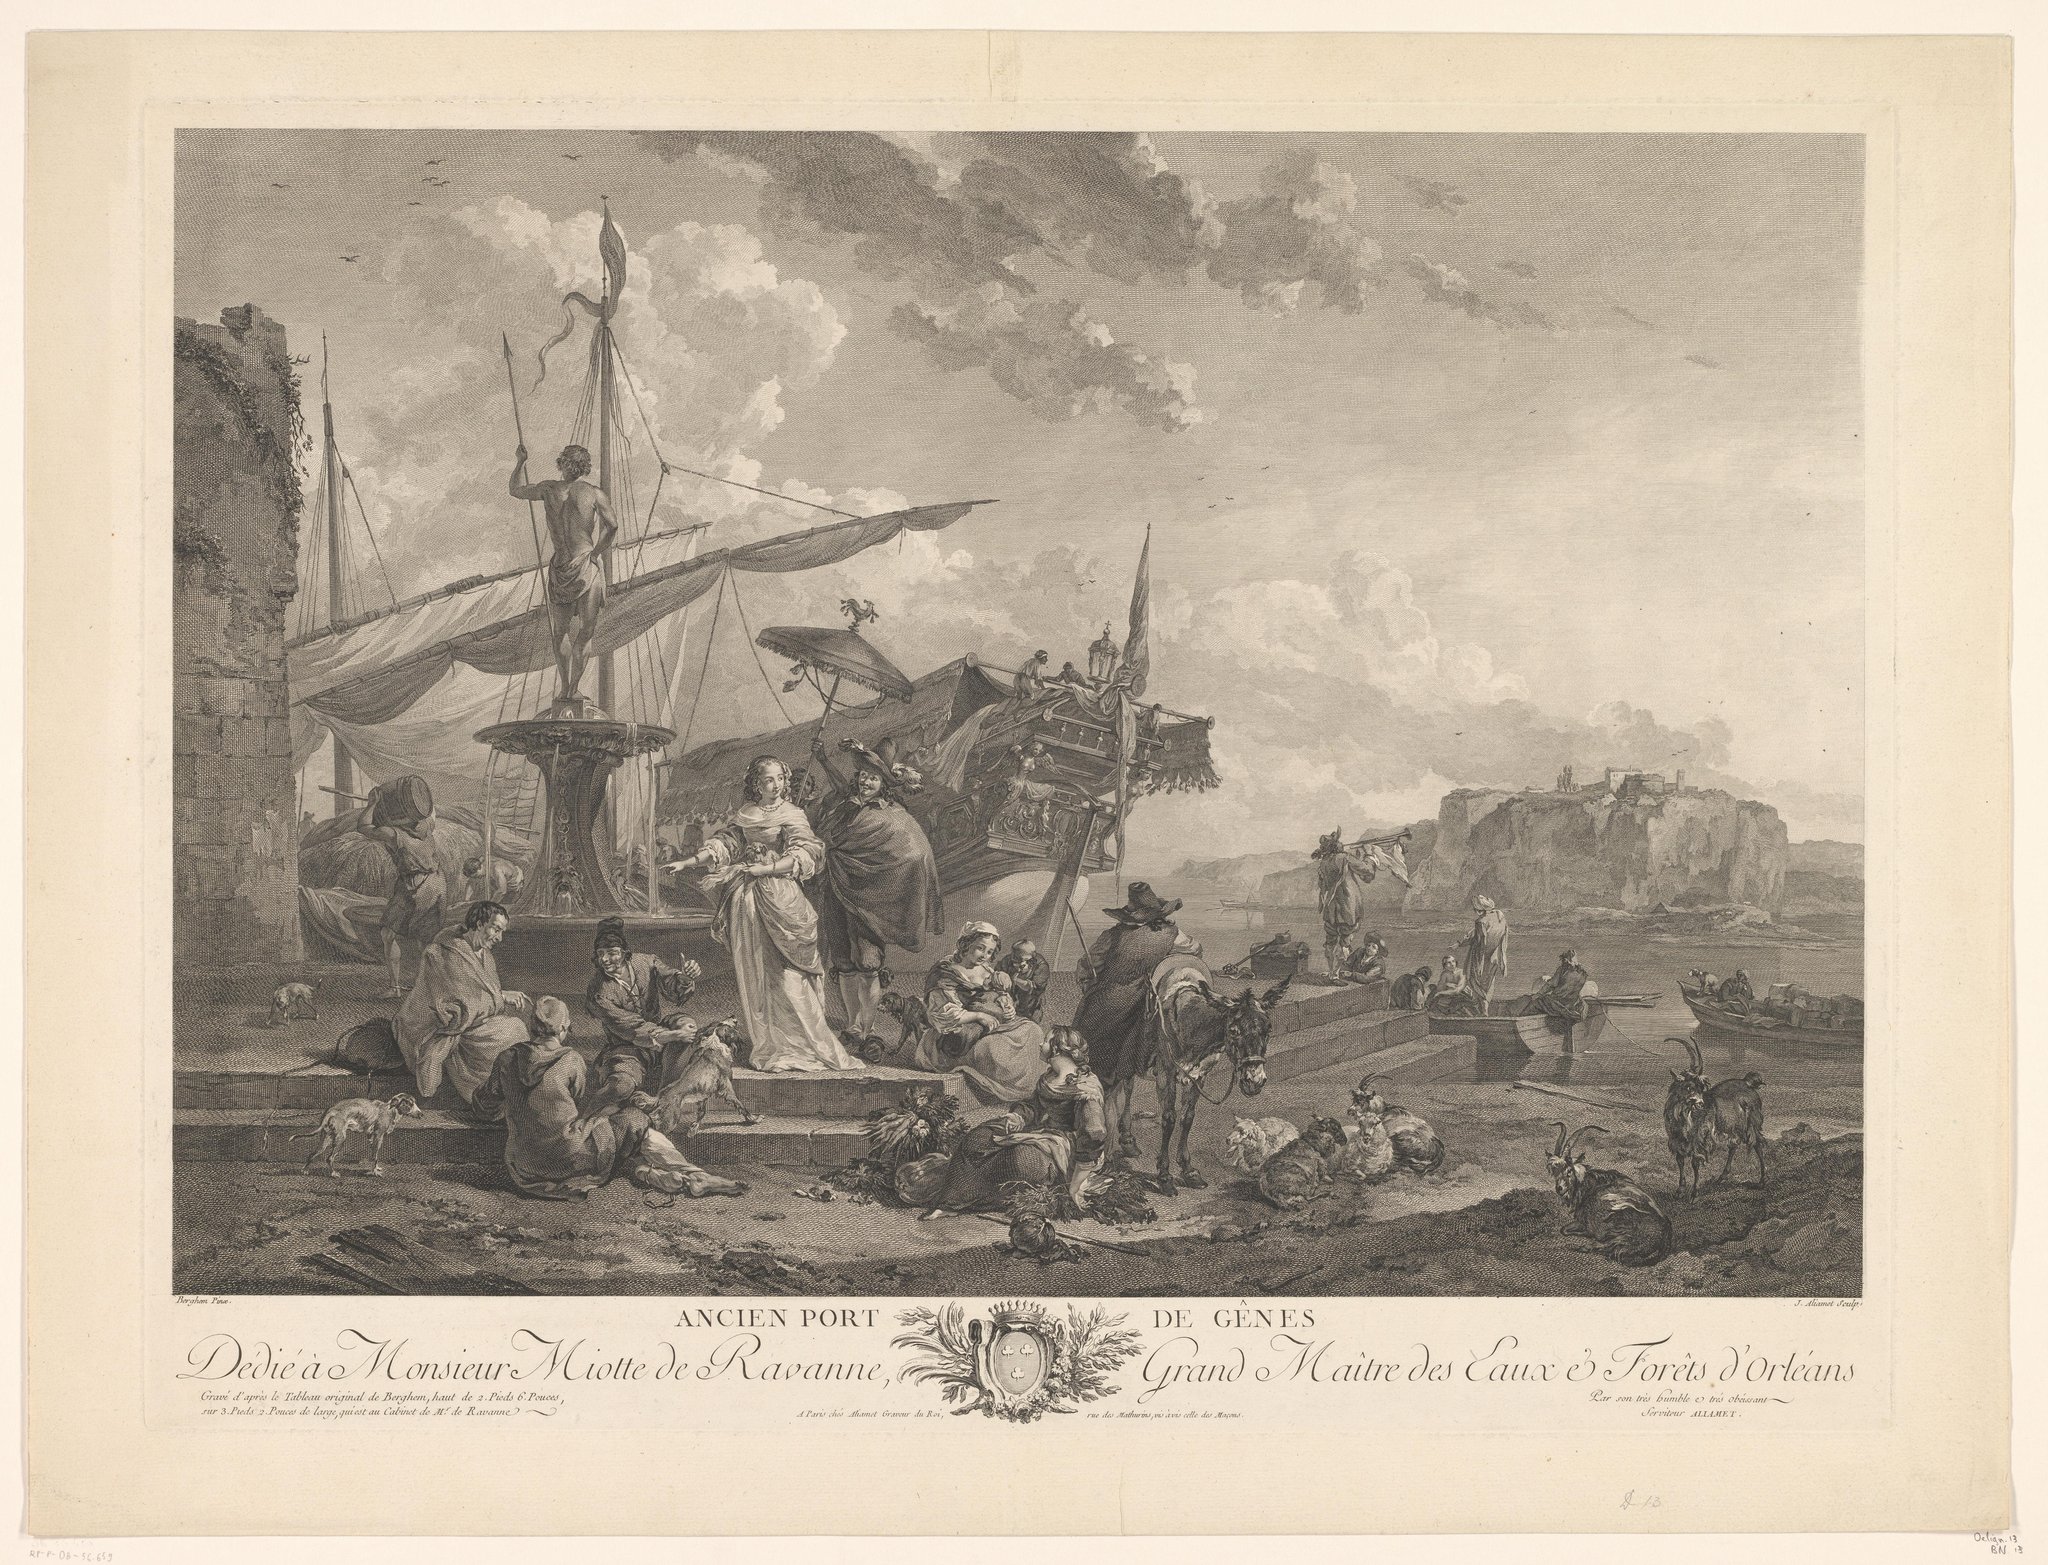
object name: print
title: Haven van Genua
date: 1736-1788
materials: paper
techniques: engraving, etching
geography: paris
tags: harbour, umbrella, goat, armorial bearing, heraldry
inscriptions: collector's mark: Lugt 240